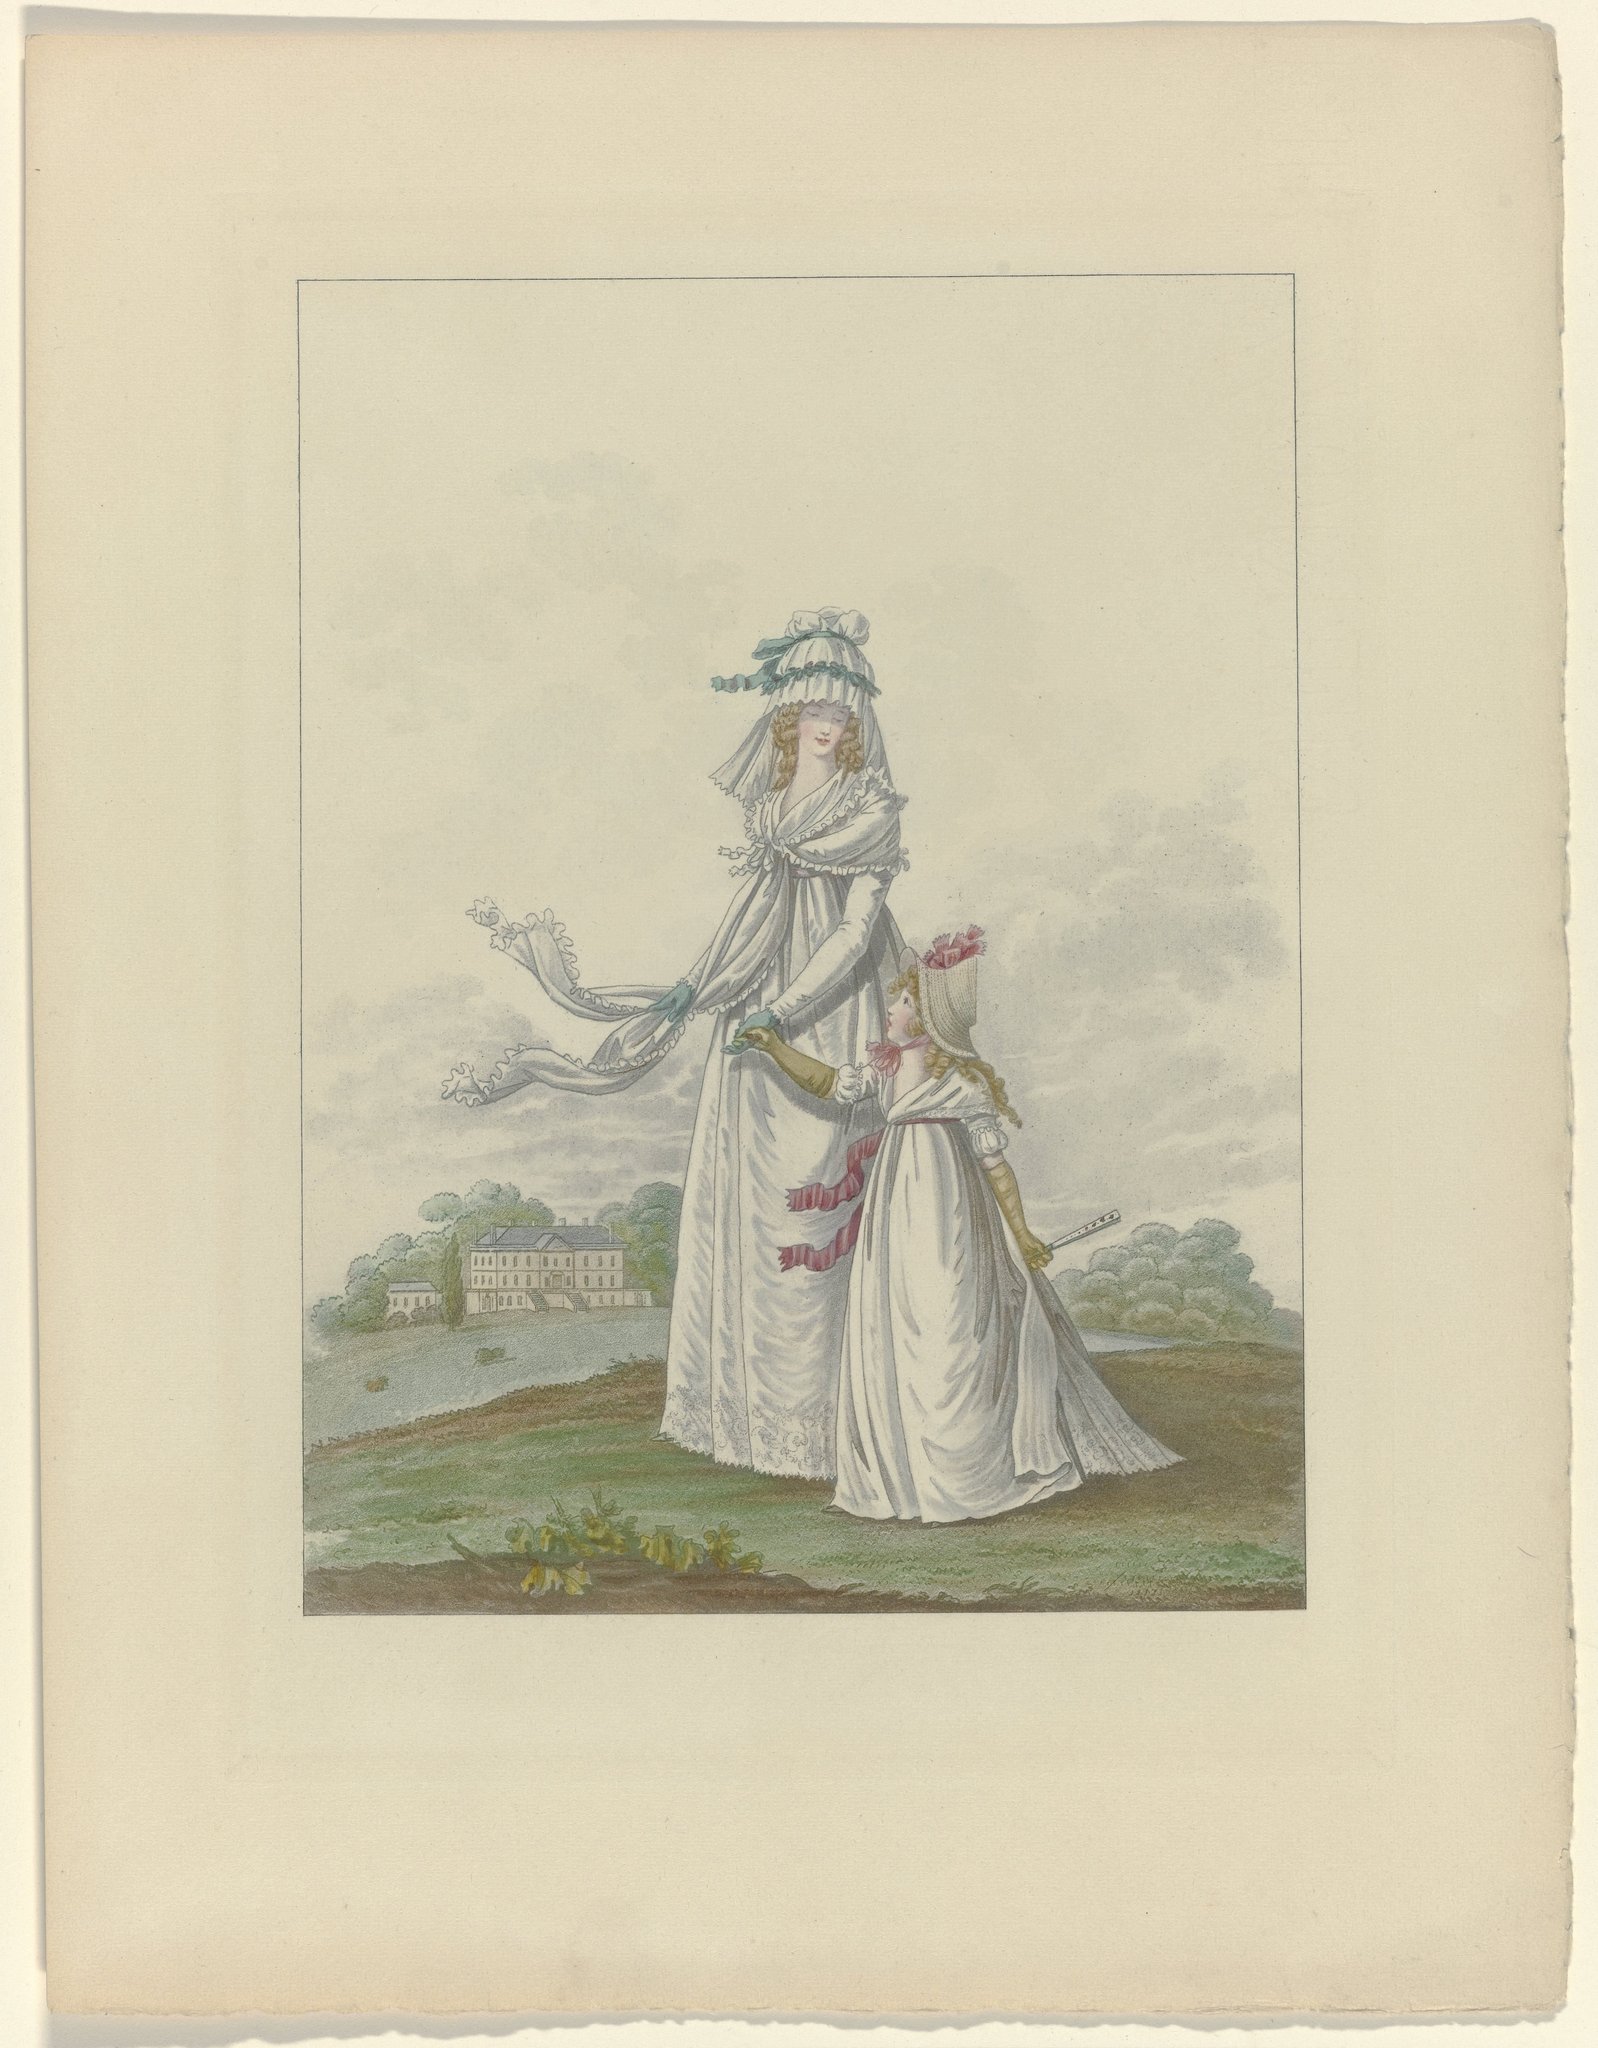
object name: fashion print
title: Modes Anglaises, Fin du XVIIIe Siécle, 1911 : Les cheveux en marteaux (...)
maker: Anonymous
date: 1795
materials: paper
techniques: hand coloring, lithograph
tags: veil (+ women's clothes), head-gear: hat (+ girls' clothes), dress, gown: day dress (+ women's clothes), fan (+ girls' clothes), head-gear: cap (+ women's clothes), fashion plates, dress, gown (+ girls' clothes)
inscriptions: caption: ‘ROBE D'ENFANT / Les cheveux en frisons courts et grandes boucles. Cabriolet de paille orné d'agréments de paille, et par devant d'un noeud de rubans lilas, les mêmes rubans noués en brides sous le menton. Robe d'enfant en calico blanc; manches courtes retournées en revers garni de dentelle. Fichu croisé - à la Barcelone - en moussline brodée au bord. Écharpe de large ruban lilas. Gants couleur jonquille. Souliers jaunes. / GALLERY OF FASHION (1795).’, caption: ‘ROBE DU JOUR / Les cheveux en marteaux et boucles légères. Bonnet et voile de fine mousseline, resserré au sommet par un étroit ruban attaché par derrière en un noeud flottant, et traversée au milieu par une guirlande de fleurs. Robe droite - à la Brunswick - en fine mousseline de l'Inde, dentelée et brodée du bas. Écharpe de satin blanc. Grand fichu de mousseline. Long mantelet de moussline blanche ruché au bord et attaché devant par un ruban de soie blanc avec les bouts flottants. Souliers et gants bleu de ciel.’, title: ‘MODES ANGLAISES / FIN DU XVIIIe SIÈCLE’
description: Kopie uit Gallery of Fashion (1795). Recueil Scheffer 20e eeuw (1911) 2 planches. Dame met meisje aan de hand in landschap.